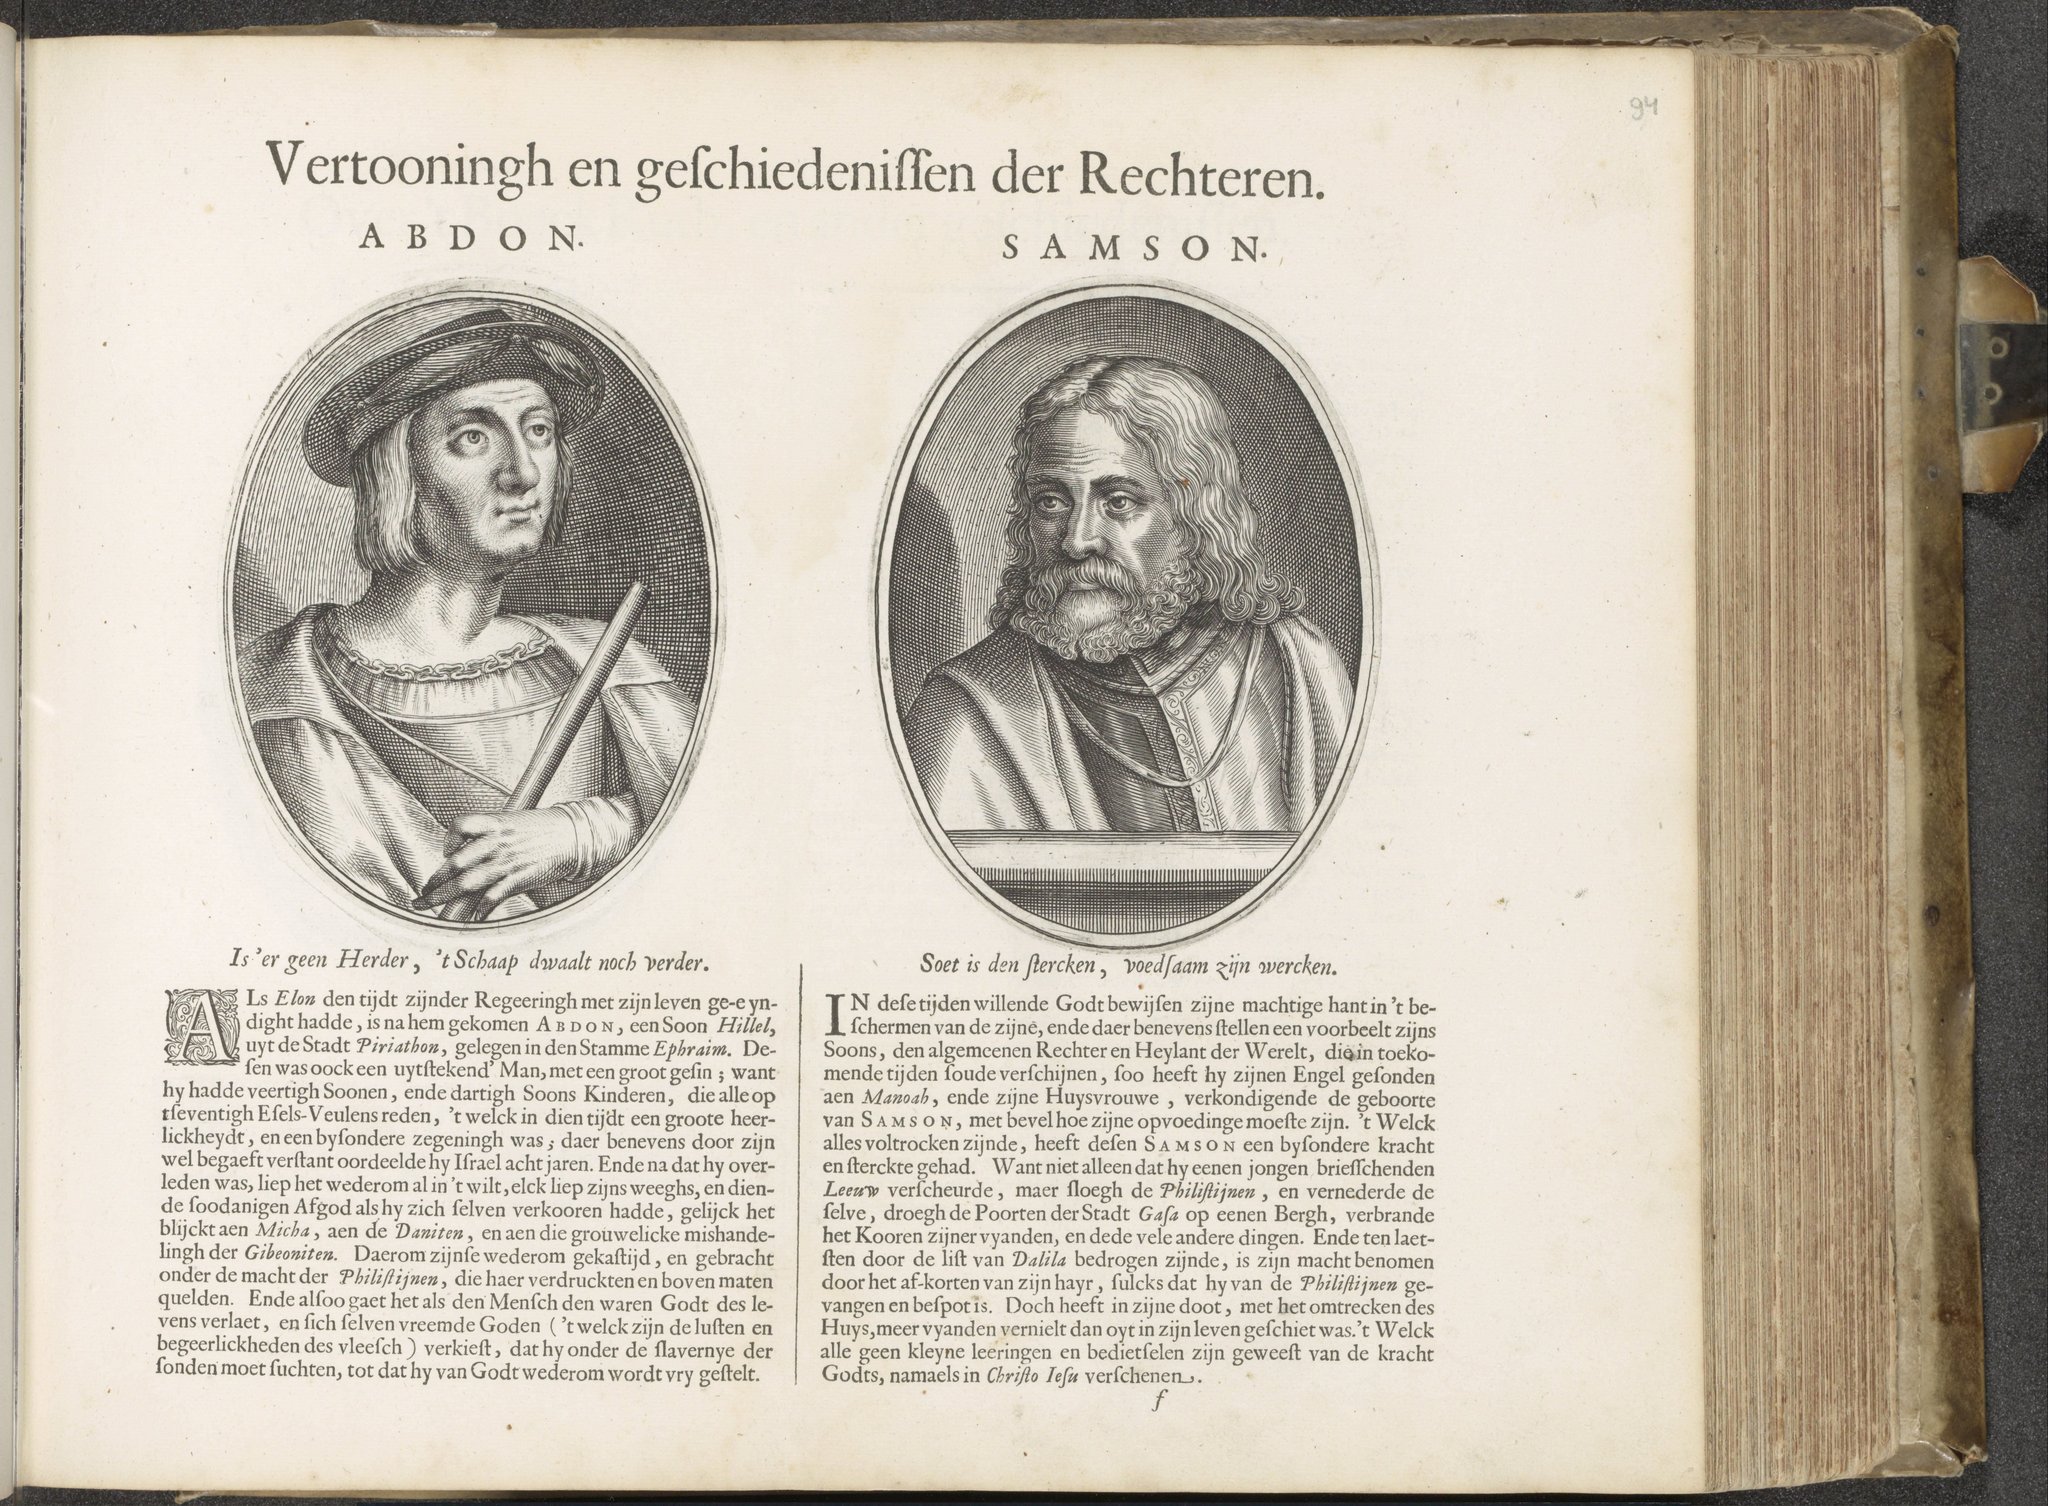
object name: album leaf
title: Vertooningh en geschiedenissen der Rechteren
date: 1610-1625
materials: paper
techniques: engraving, letterpress printing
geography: amsterdam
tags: montilla, granada, generaal, staatsman, legeraanvoerder, gonzalo fernández de córdoba, jacques ii de chabannes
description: Portretten van Jacques Chabannes en Gonzalo Fernandez de Cordoba, in dit album gebruikt als afbeeldingen van respectievelijk Abdon en Simson, twee oudtestamentische rechters. De begeleidende tekst begint met een kleine gedecoreerde initiaal A. Het blad maakt deel uit van een album.